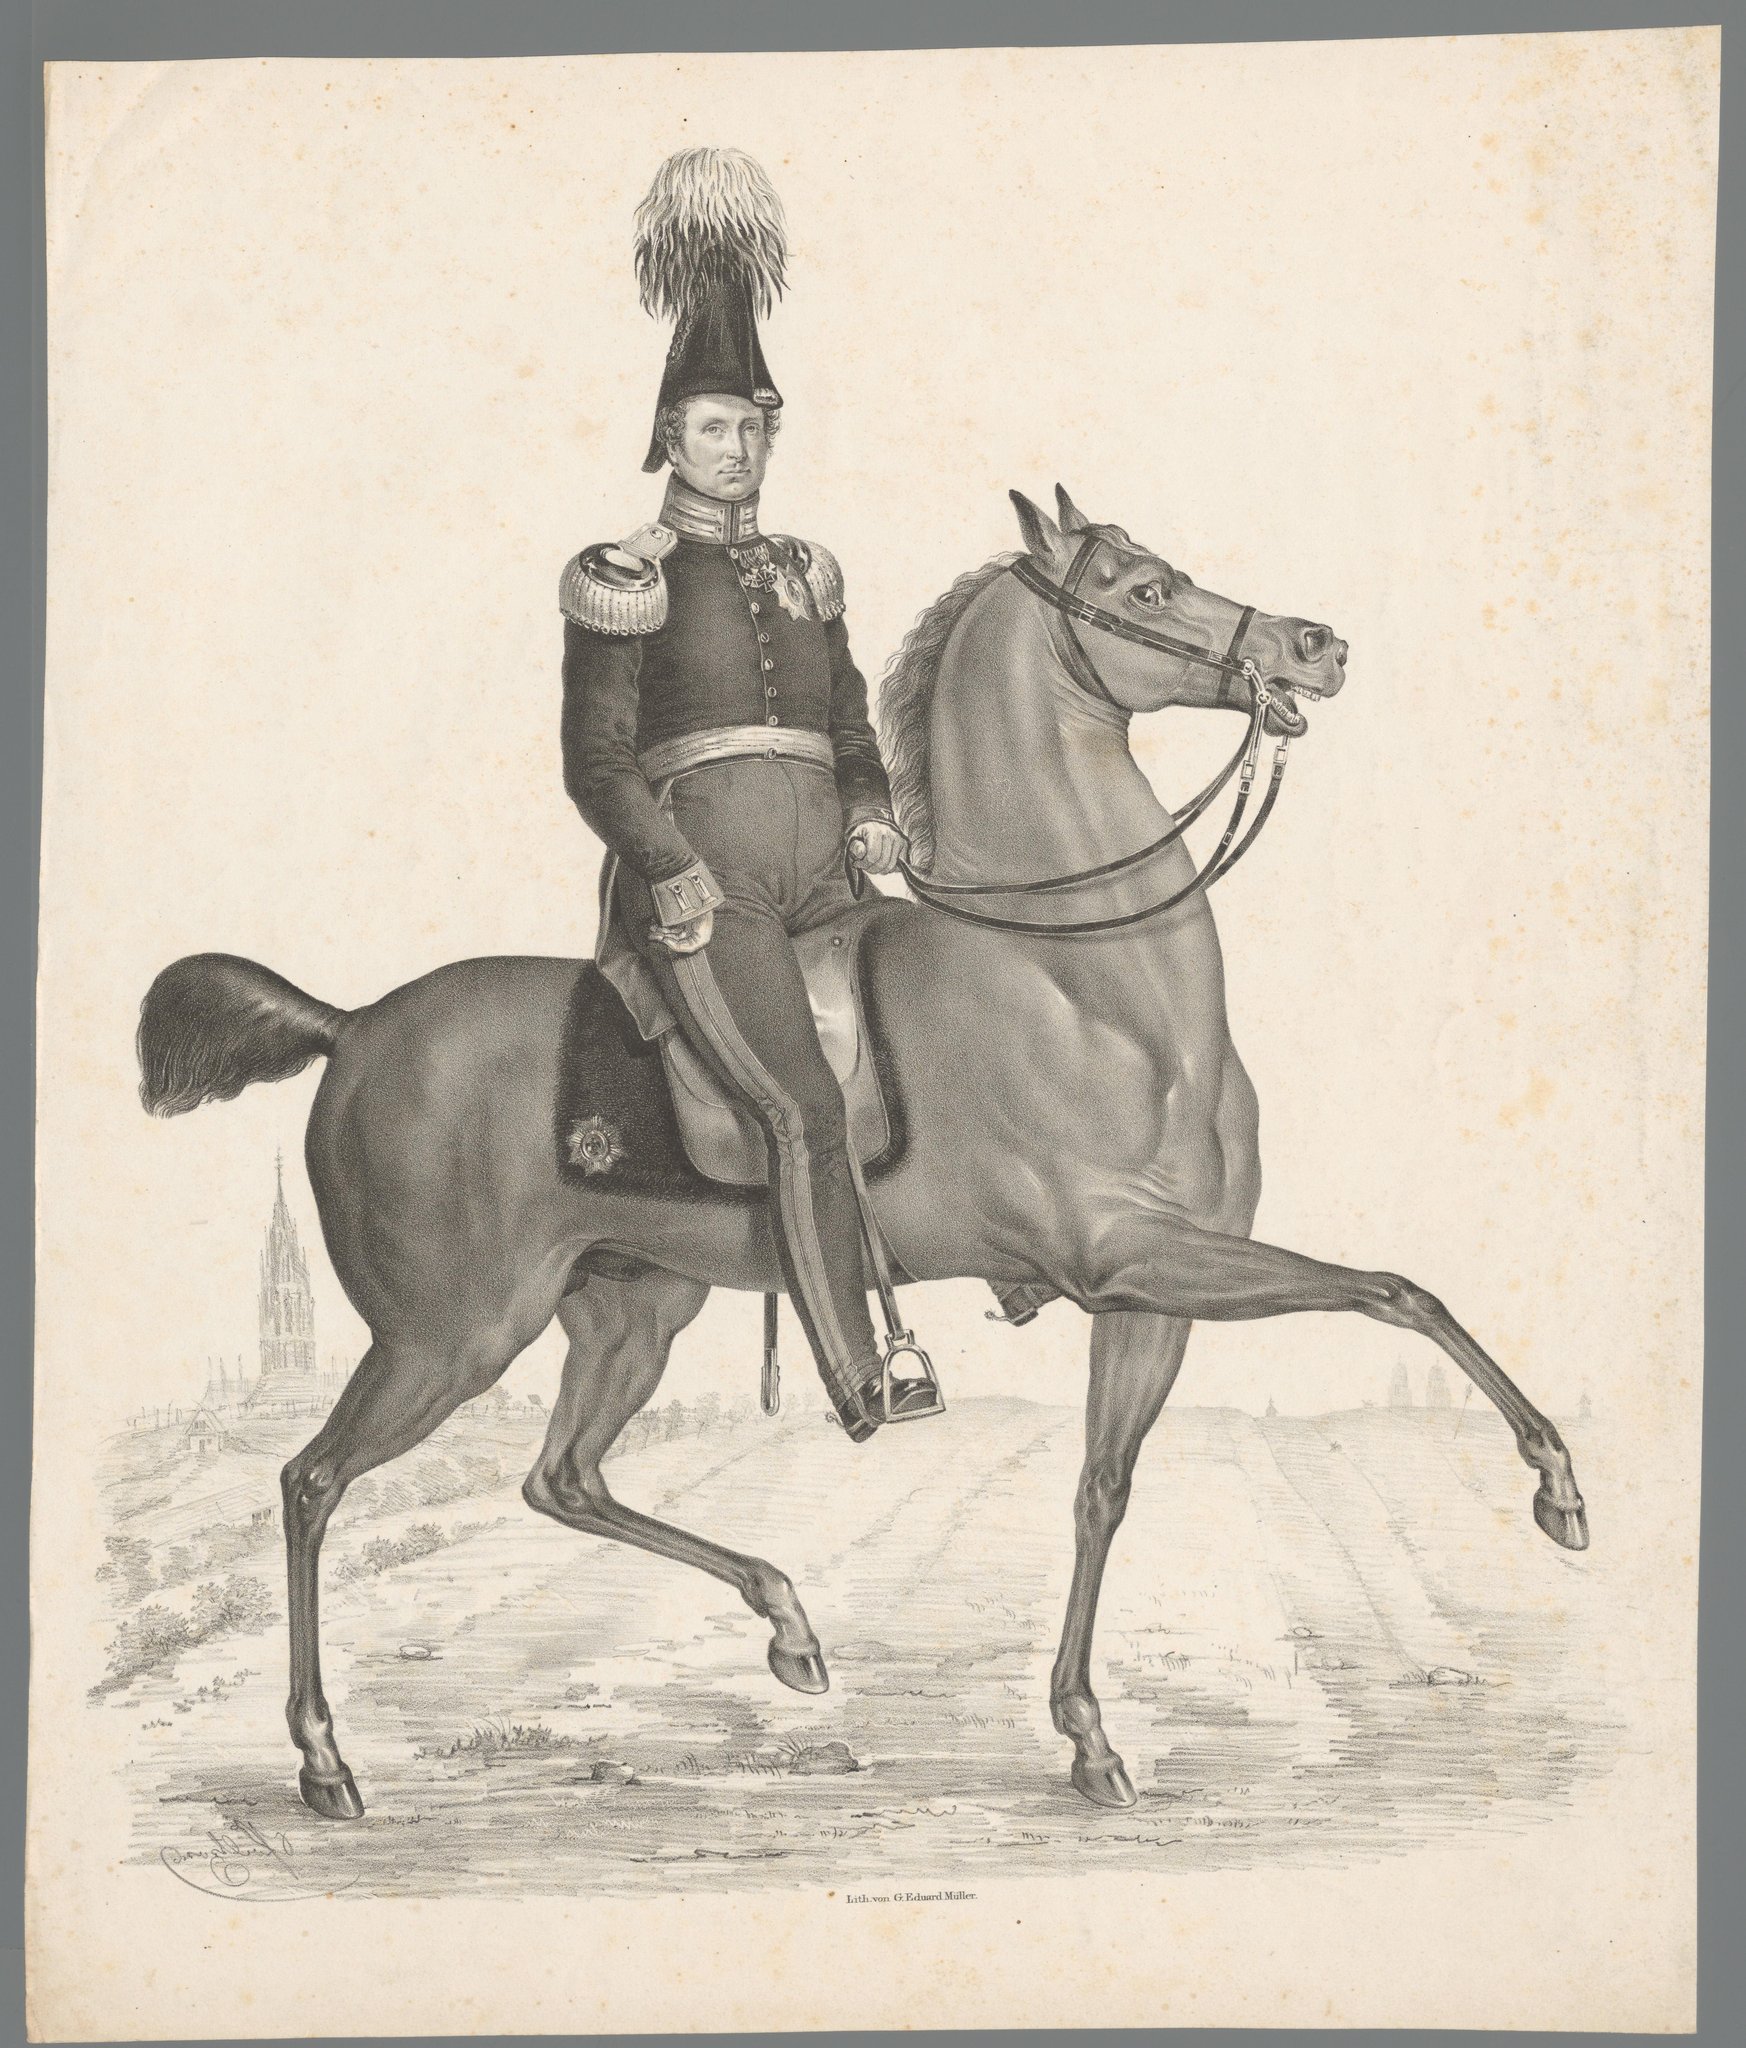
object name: print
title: Portret van Frederik Willem III te paard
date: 1820-1850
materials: paper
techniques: lithograph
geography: berlin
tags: frederik willem iii koning van pruisen, riding a horse, ass, or mule; rider, horseman, adult man, historical persons, horse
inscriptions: collector's mark: Lugt 2228